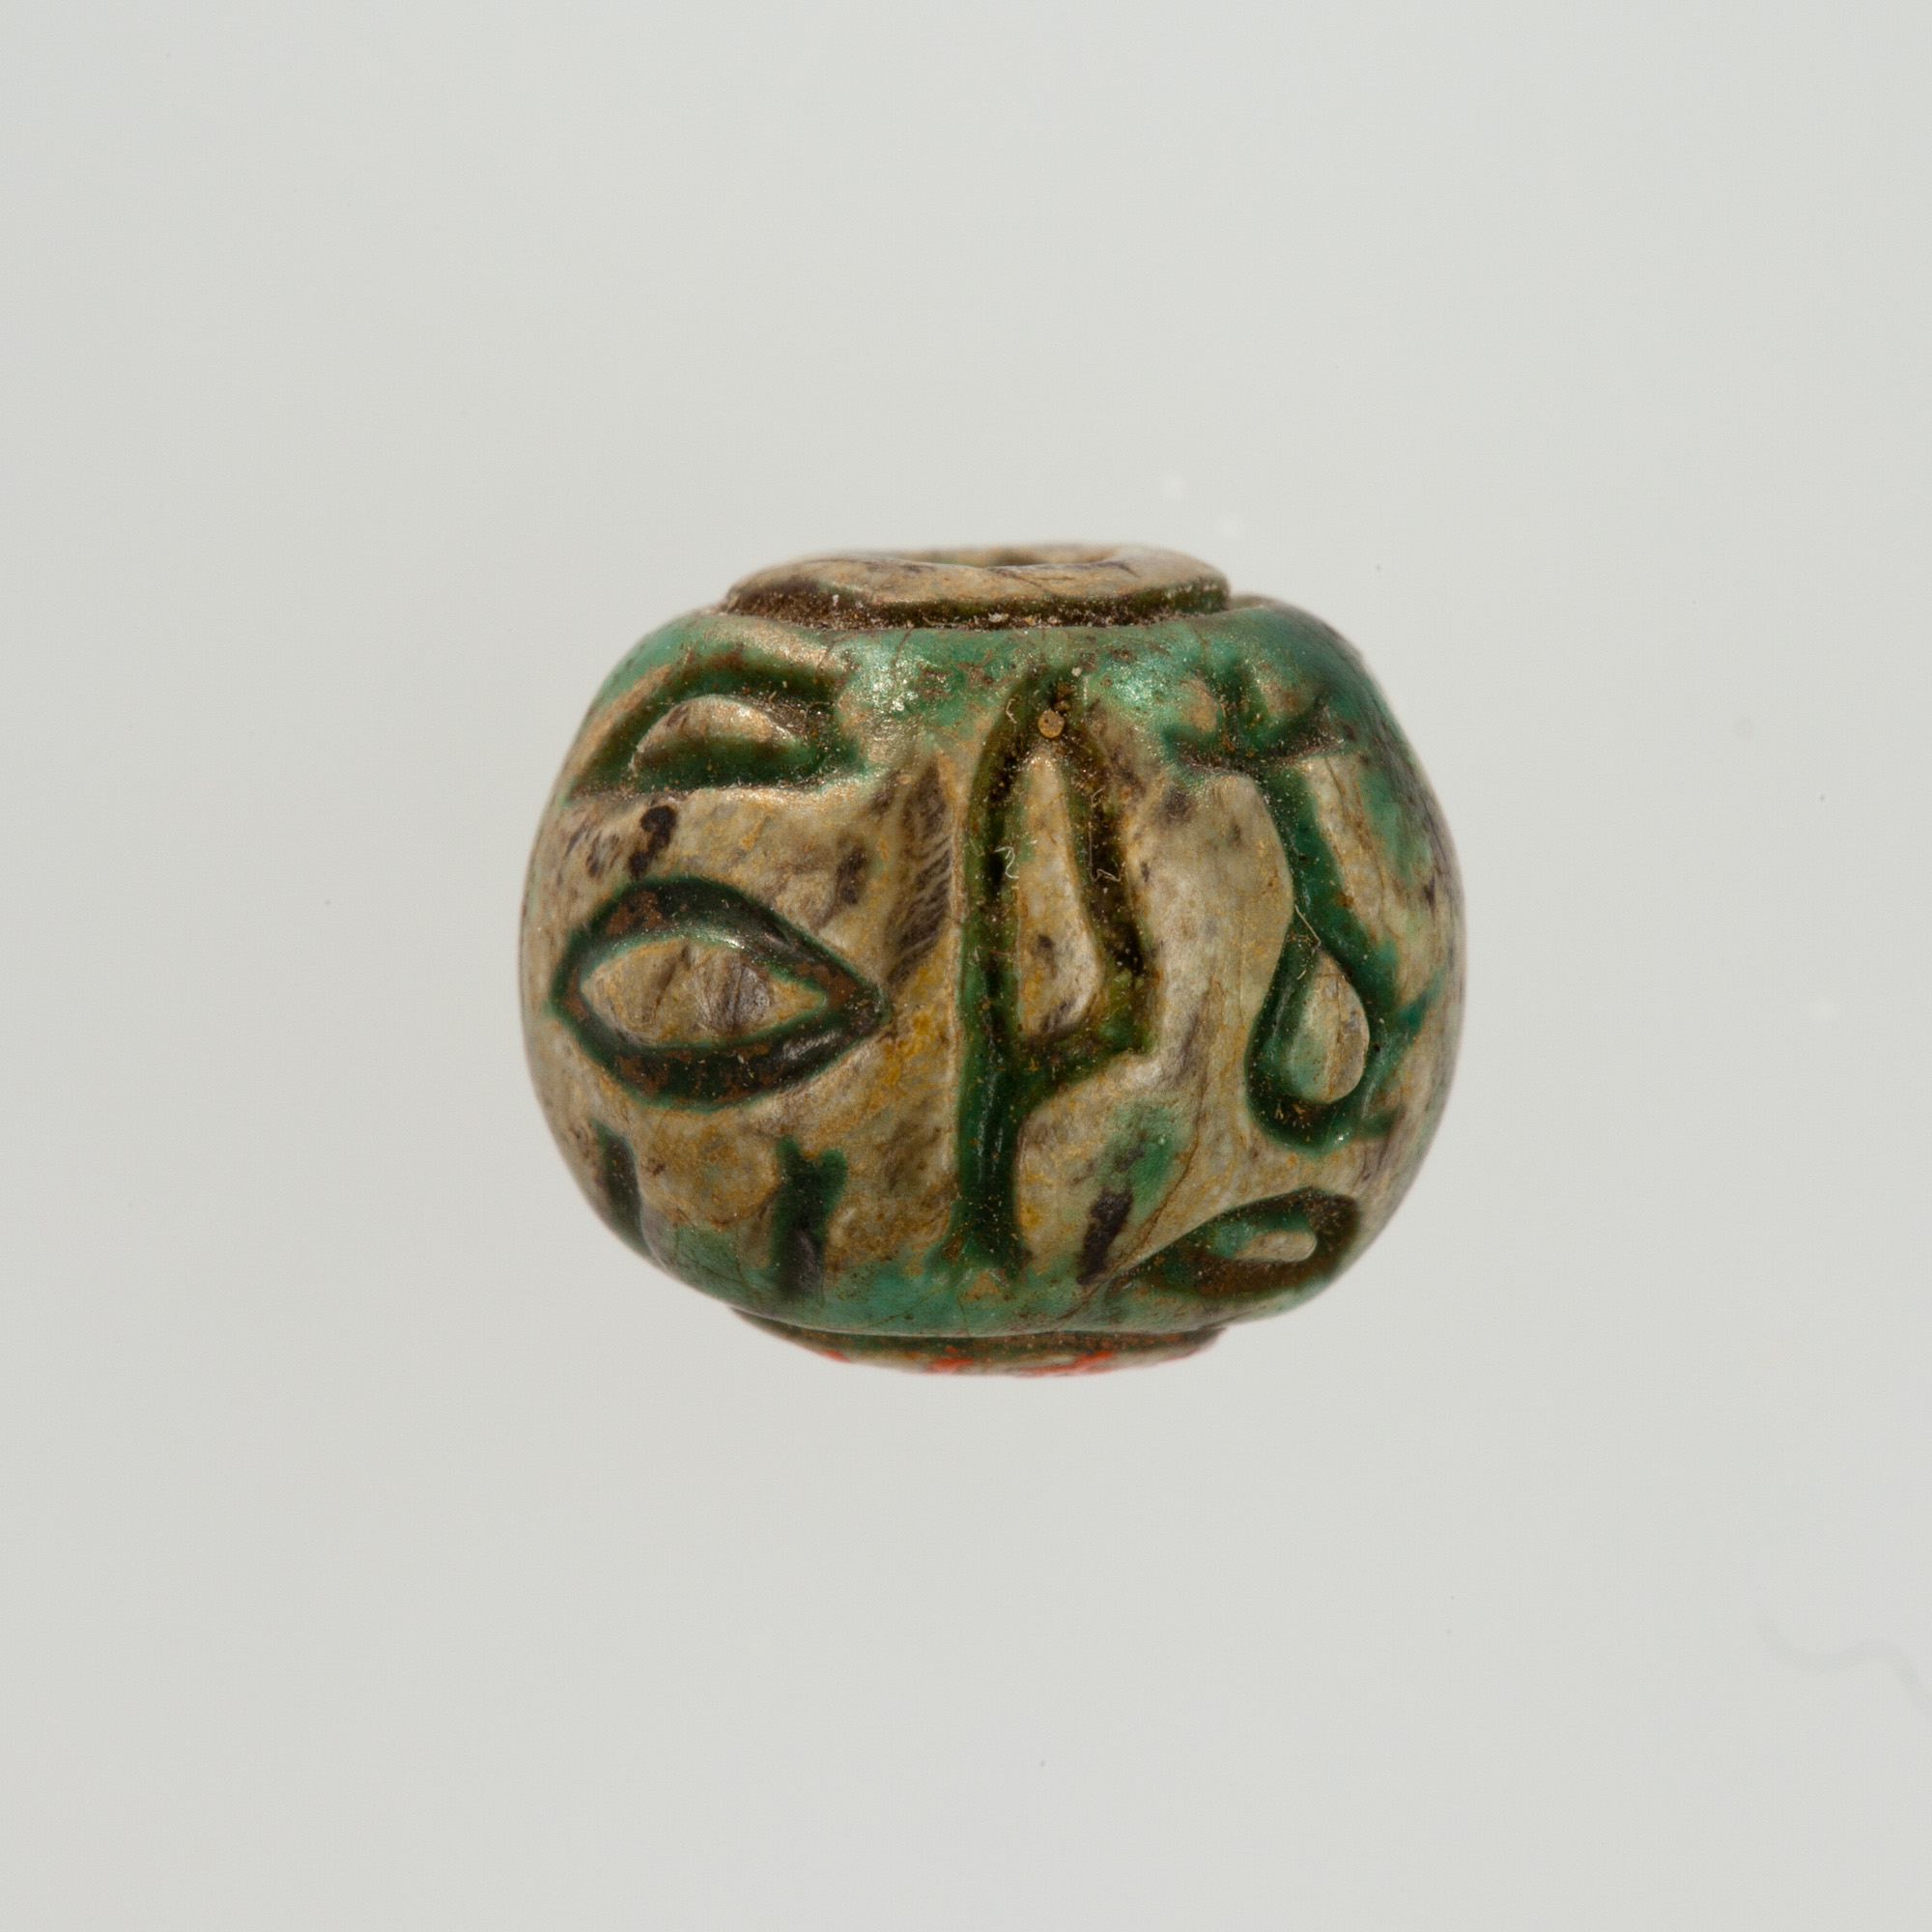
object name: bead, ahmose nefertari, king's wife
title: Bead Inscribed for the King's Wife (Ahmose-)Nefertari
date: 1550-1525 BCE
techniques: glazing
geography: egypt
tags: hieroglyphs